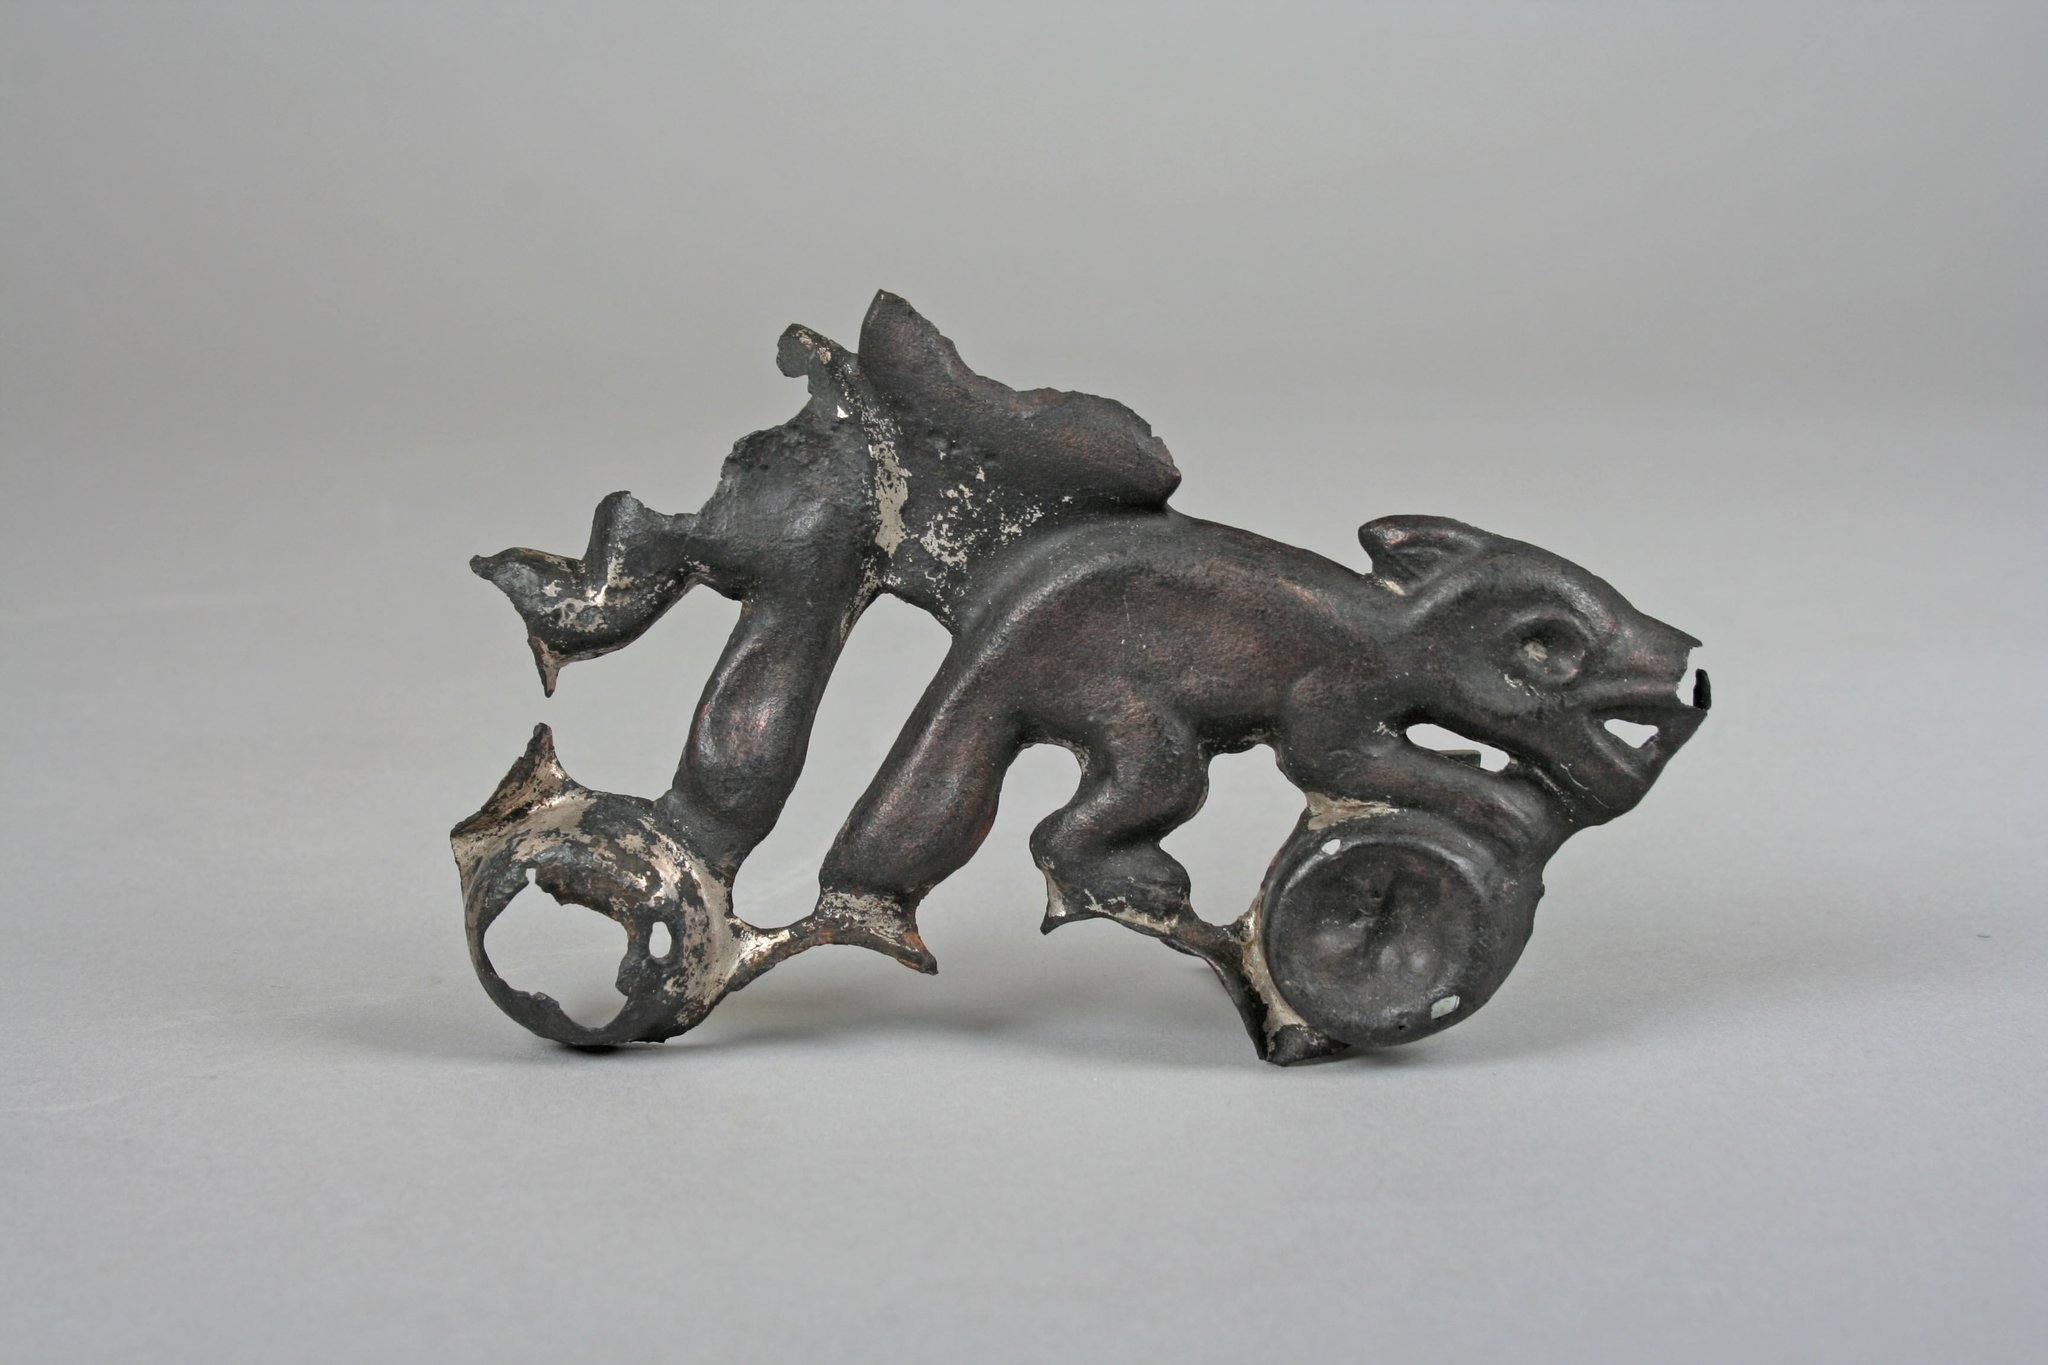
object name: ornament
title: Copper Belt Fragment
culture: moche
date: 1-500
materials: copper, silver gilt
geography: peru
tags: animals